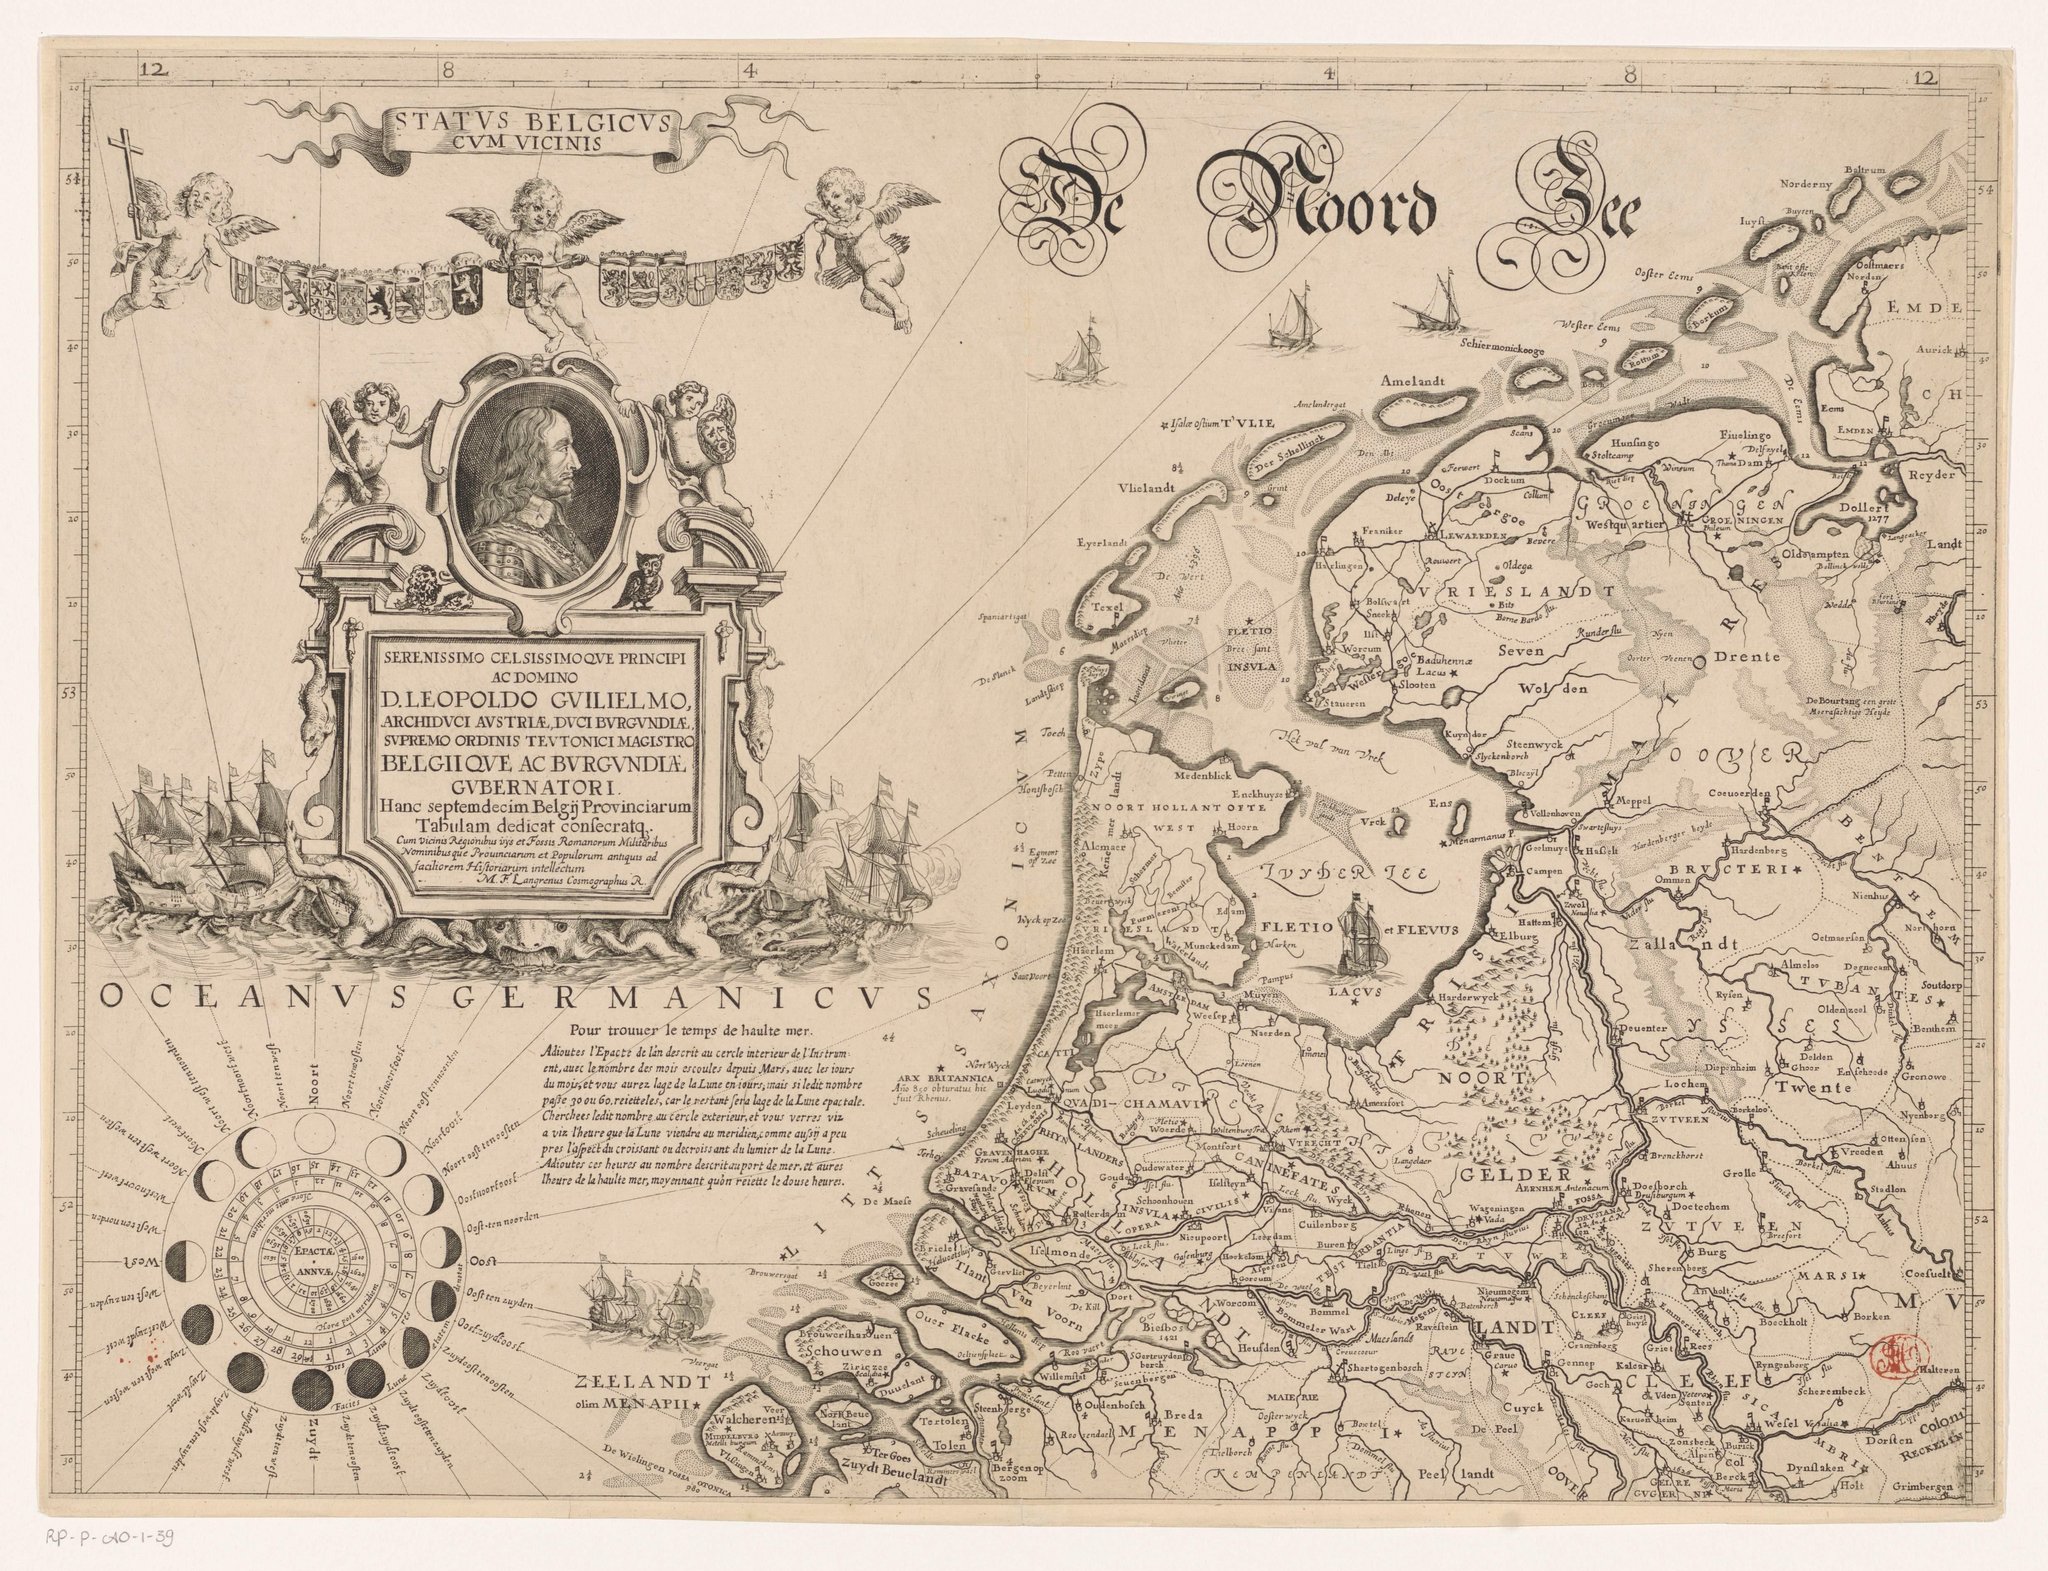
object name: map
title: Status Belgicus cum vicinis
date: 1647-1656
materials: paper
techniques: engraving, etching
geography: brussels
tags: vienna, leopold willem van oostenrijk (landvoogd der zuidelijke nederlanden), coat of arms (as symbol of the state, etc.), maps of separate countries or regions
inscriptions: collector's mark: Lugt 195, collector's mark: Lugt 2228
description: Linksboven cartouche met titel, daaronder drie putti die de wapens van de Zeventien Provinciën dragen. Daaronder een cartouche met portret van aartshertog Leopold Willem van Oostenrijk (landvoogd der Zuidelijke Nederlanden) en een Latijnse tekst waarin de kaart aan hem wordt opgedragen. Linksonder een windroos met windrichtingen in het Nederlands. Daarnaast een Franstalige uitleg over de tijdberekening op zee. Langs de linker-, boven- en rechterkant een gradenverdeling.